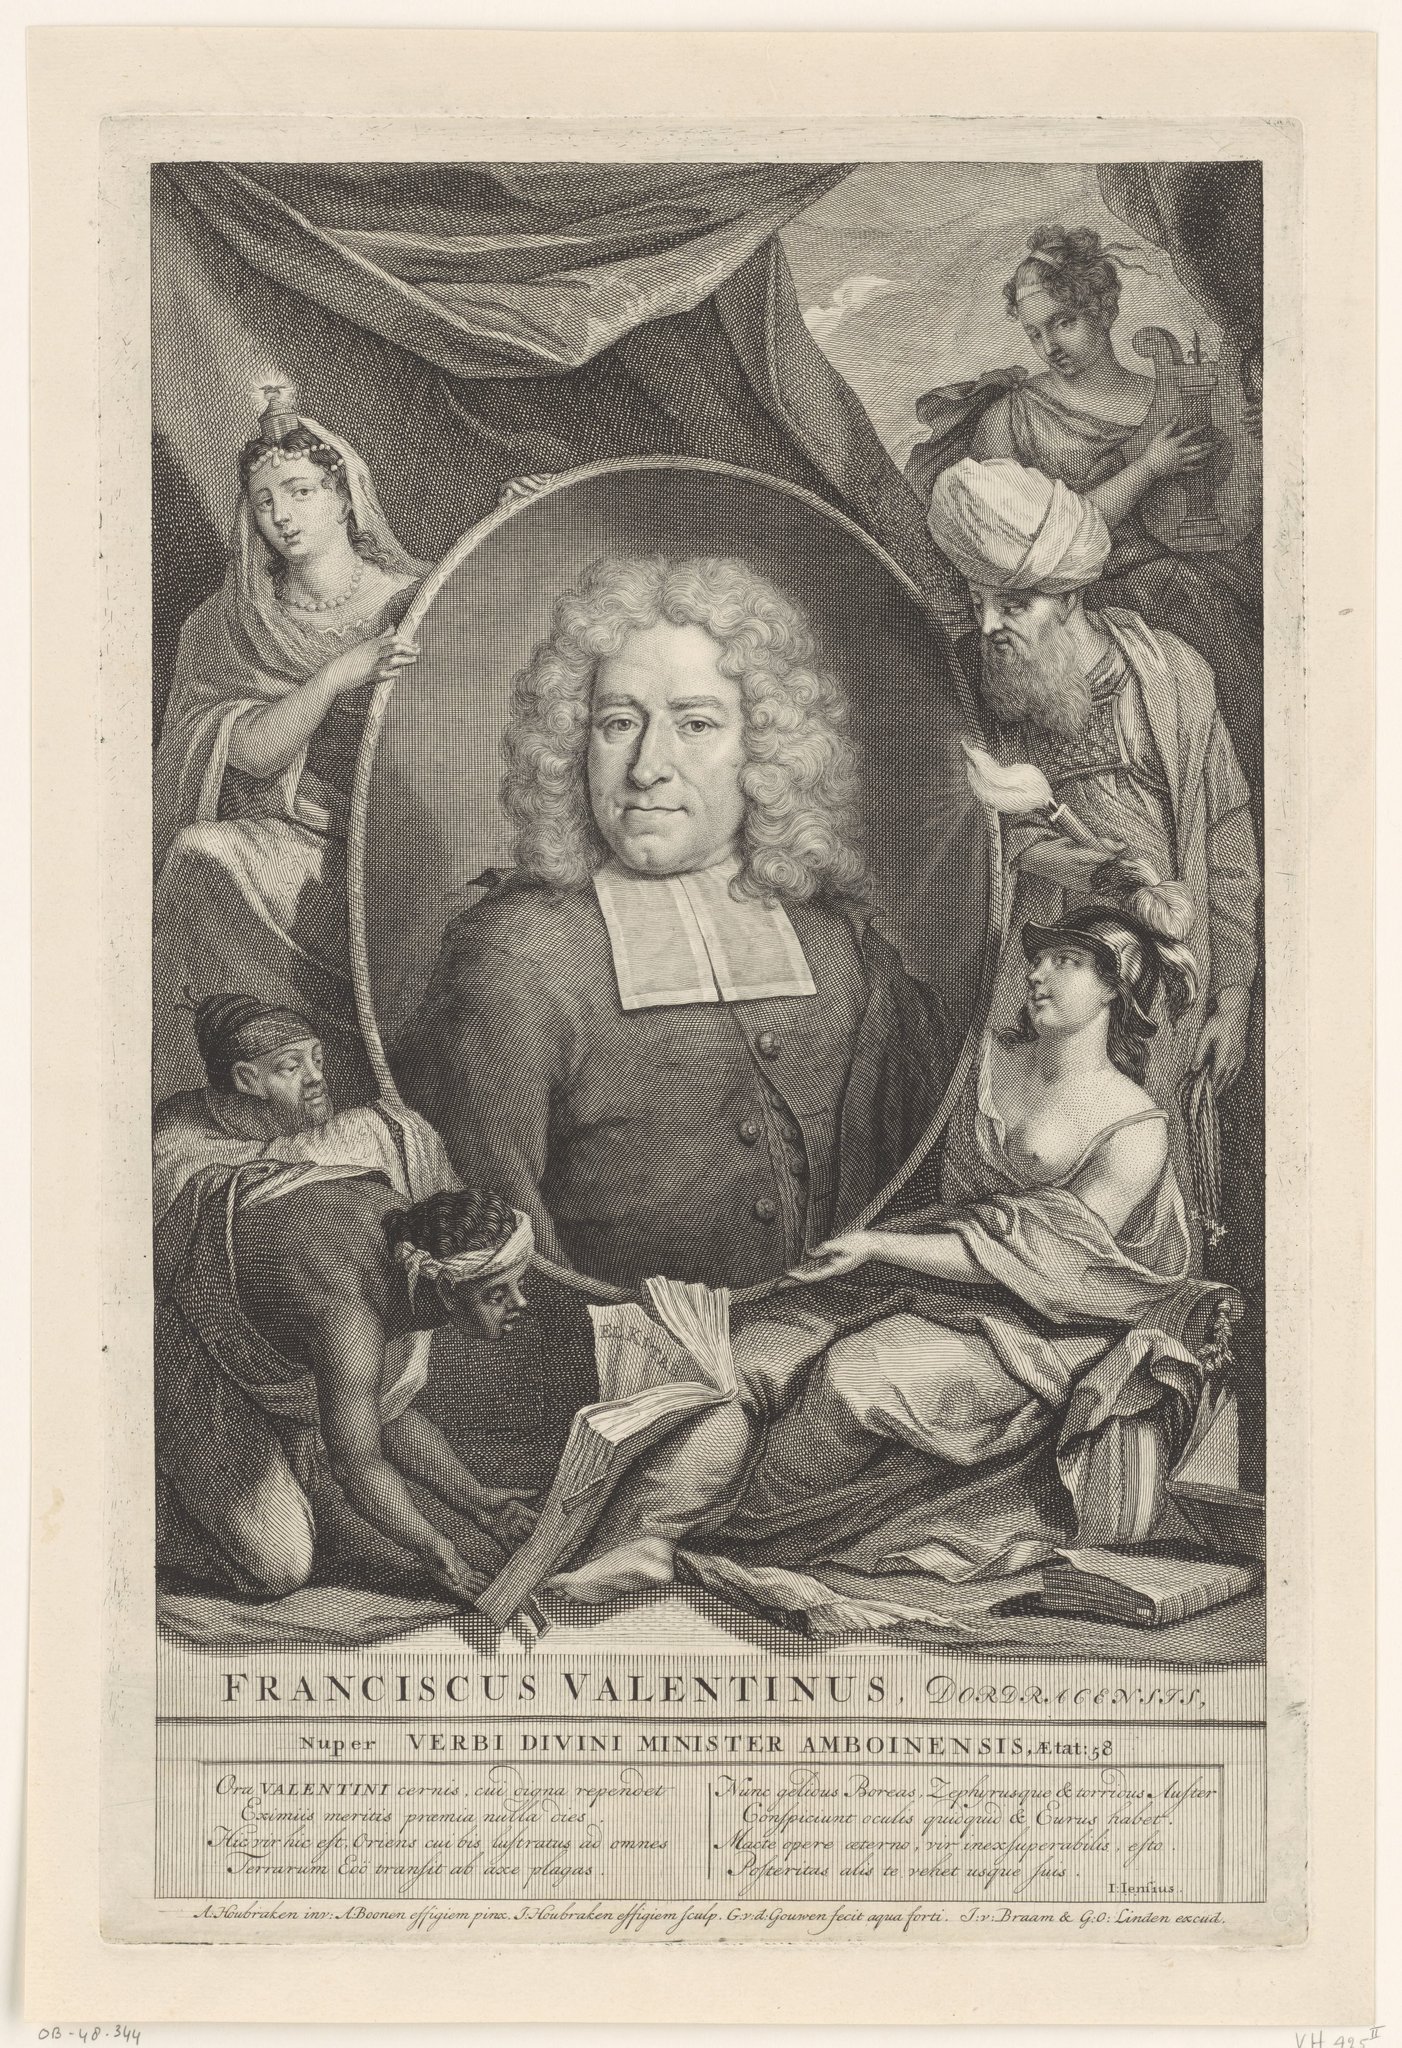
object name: print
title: Portret van François Valentijn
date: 1724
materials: paper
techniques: engraving, etching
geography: amsterdam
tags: dordrecht, the hague, asiatic races and peoples, minerva as patroness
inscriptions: collector's mark: Lugt 1120, collector's mark: Lugt 2228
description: Portret van de historicus en dominee François Valentijn op 38-jarige leeftijd, in een ovaal medaillon, dat wordt vastgehouden door Minerva (de wetenschap) en het Geloof (vrouw met kerkgebouw en duif op haar hoofd). Het portret wordt omringd door oosterse figuren en boeken die verwijzen naar zijn reizen naar Azië en de werken die hij hierover schreef. Onder de voorstelling de naam en gegevens van de geportretteerde in twee regels in het Latijn. Daaronder twee kolommen van elk vier regels met een vers in het Latijn